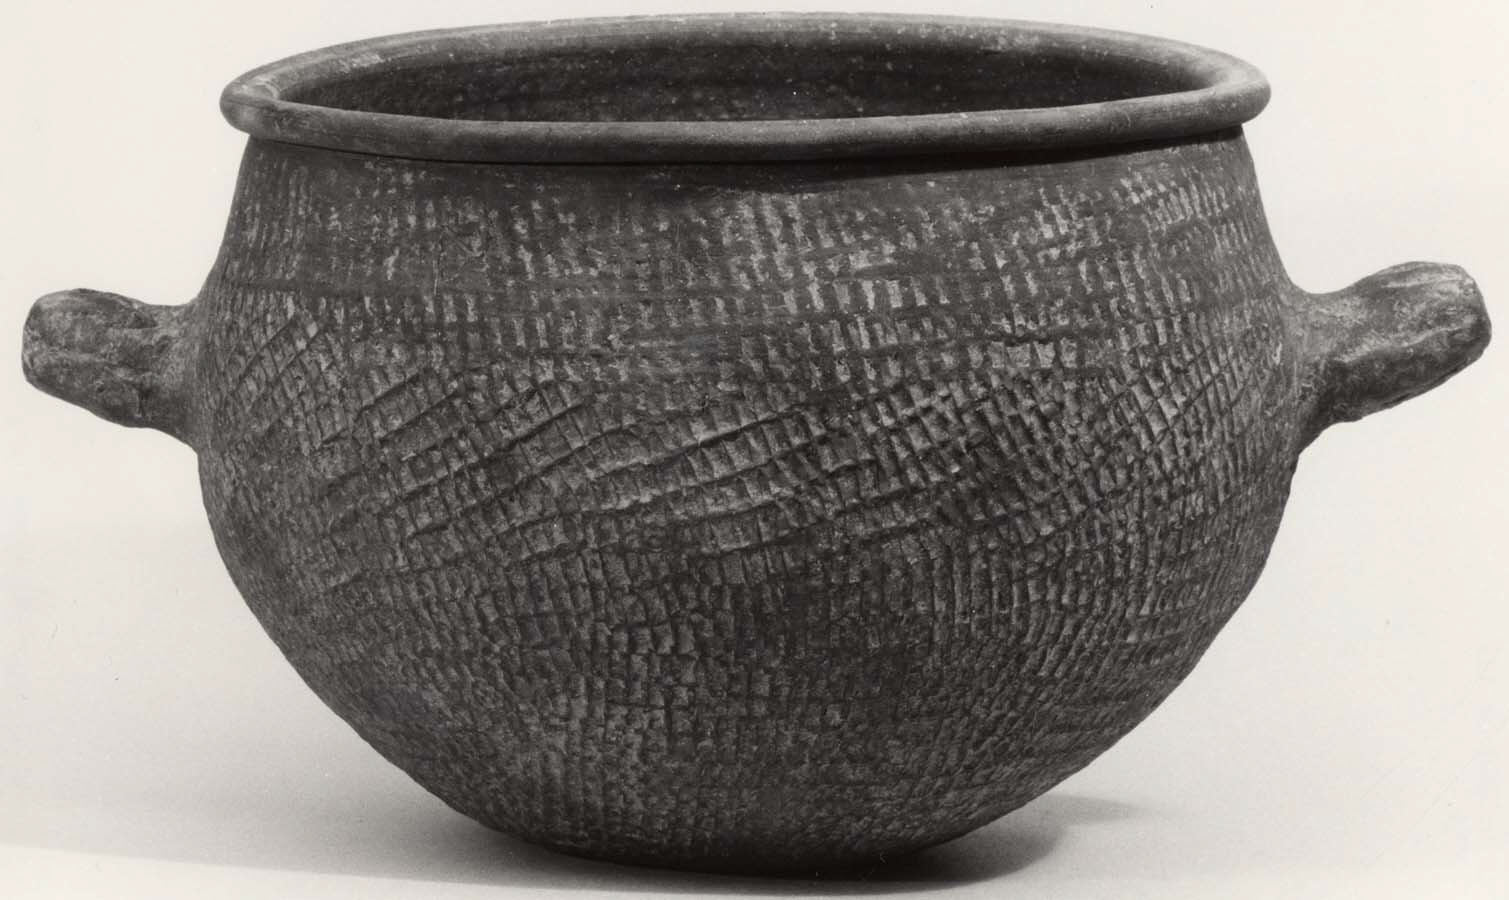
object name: vessel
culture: korean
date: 301-500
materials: earthenware